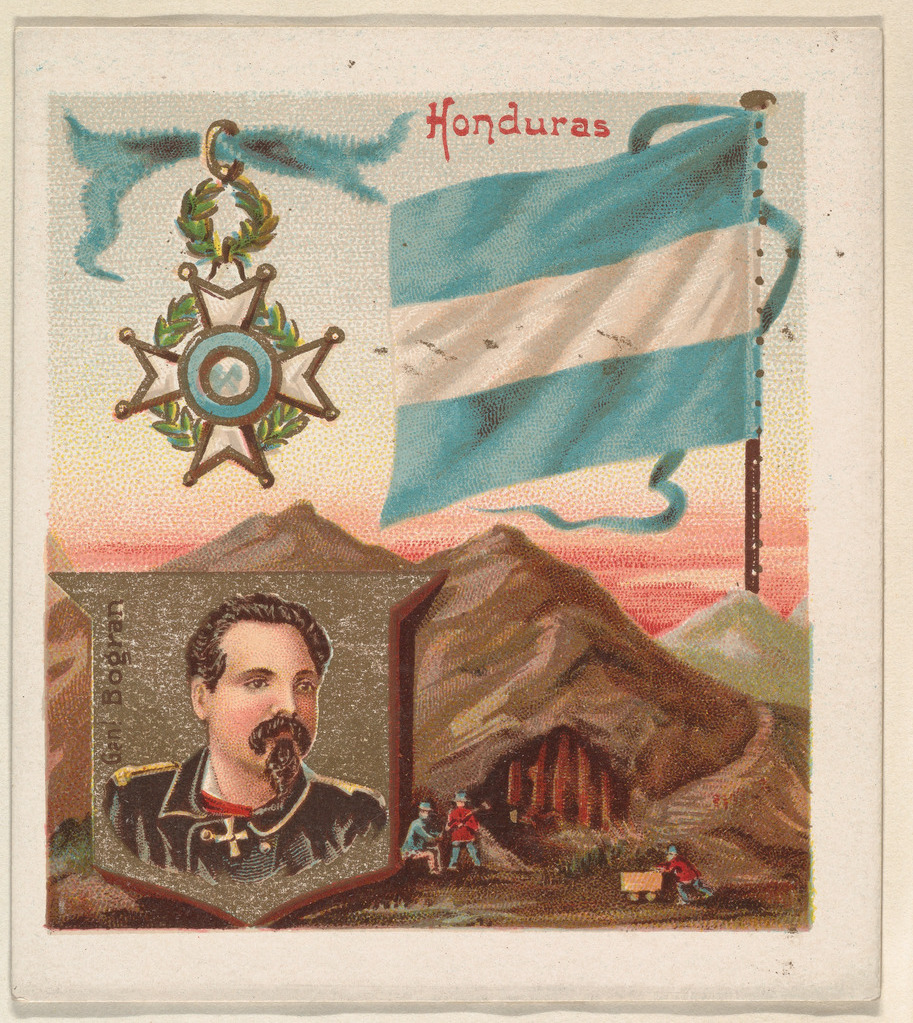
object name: print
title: Honduras, from the International Cards series (N238), issued by Kinney Bros.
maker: kinney brothers tobacco company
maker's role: publisher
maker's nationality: american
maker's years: 1869-2011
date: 1888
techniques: color lithograph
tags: men,flags